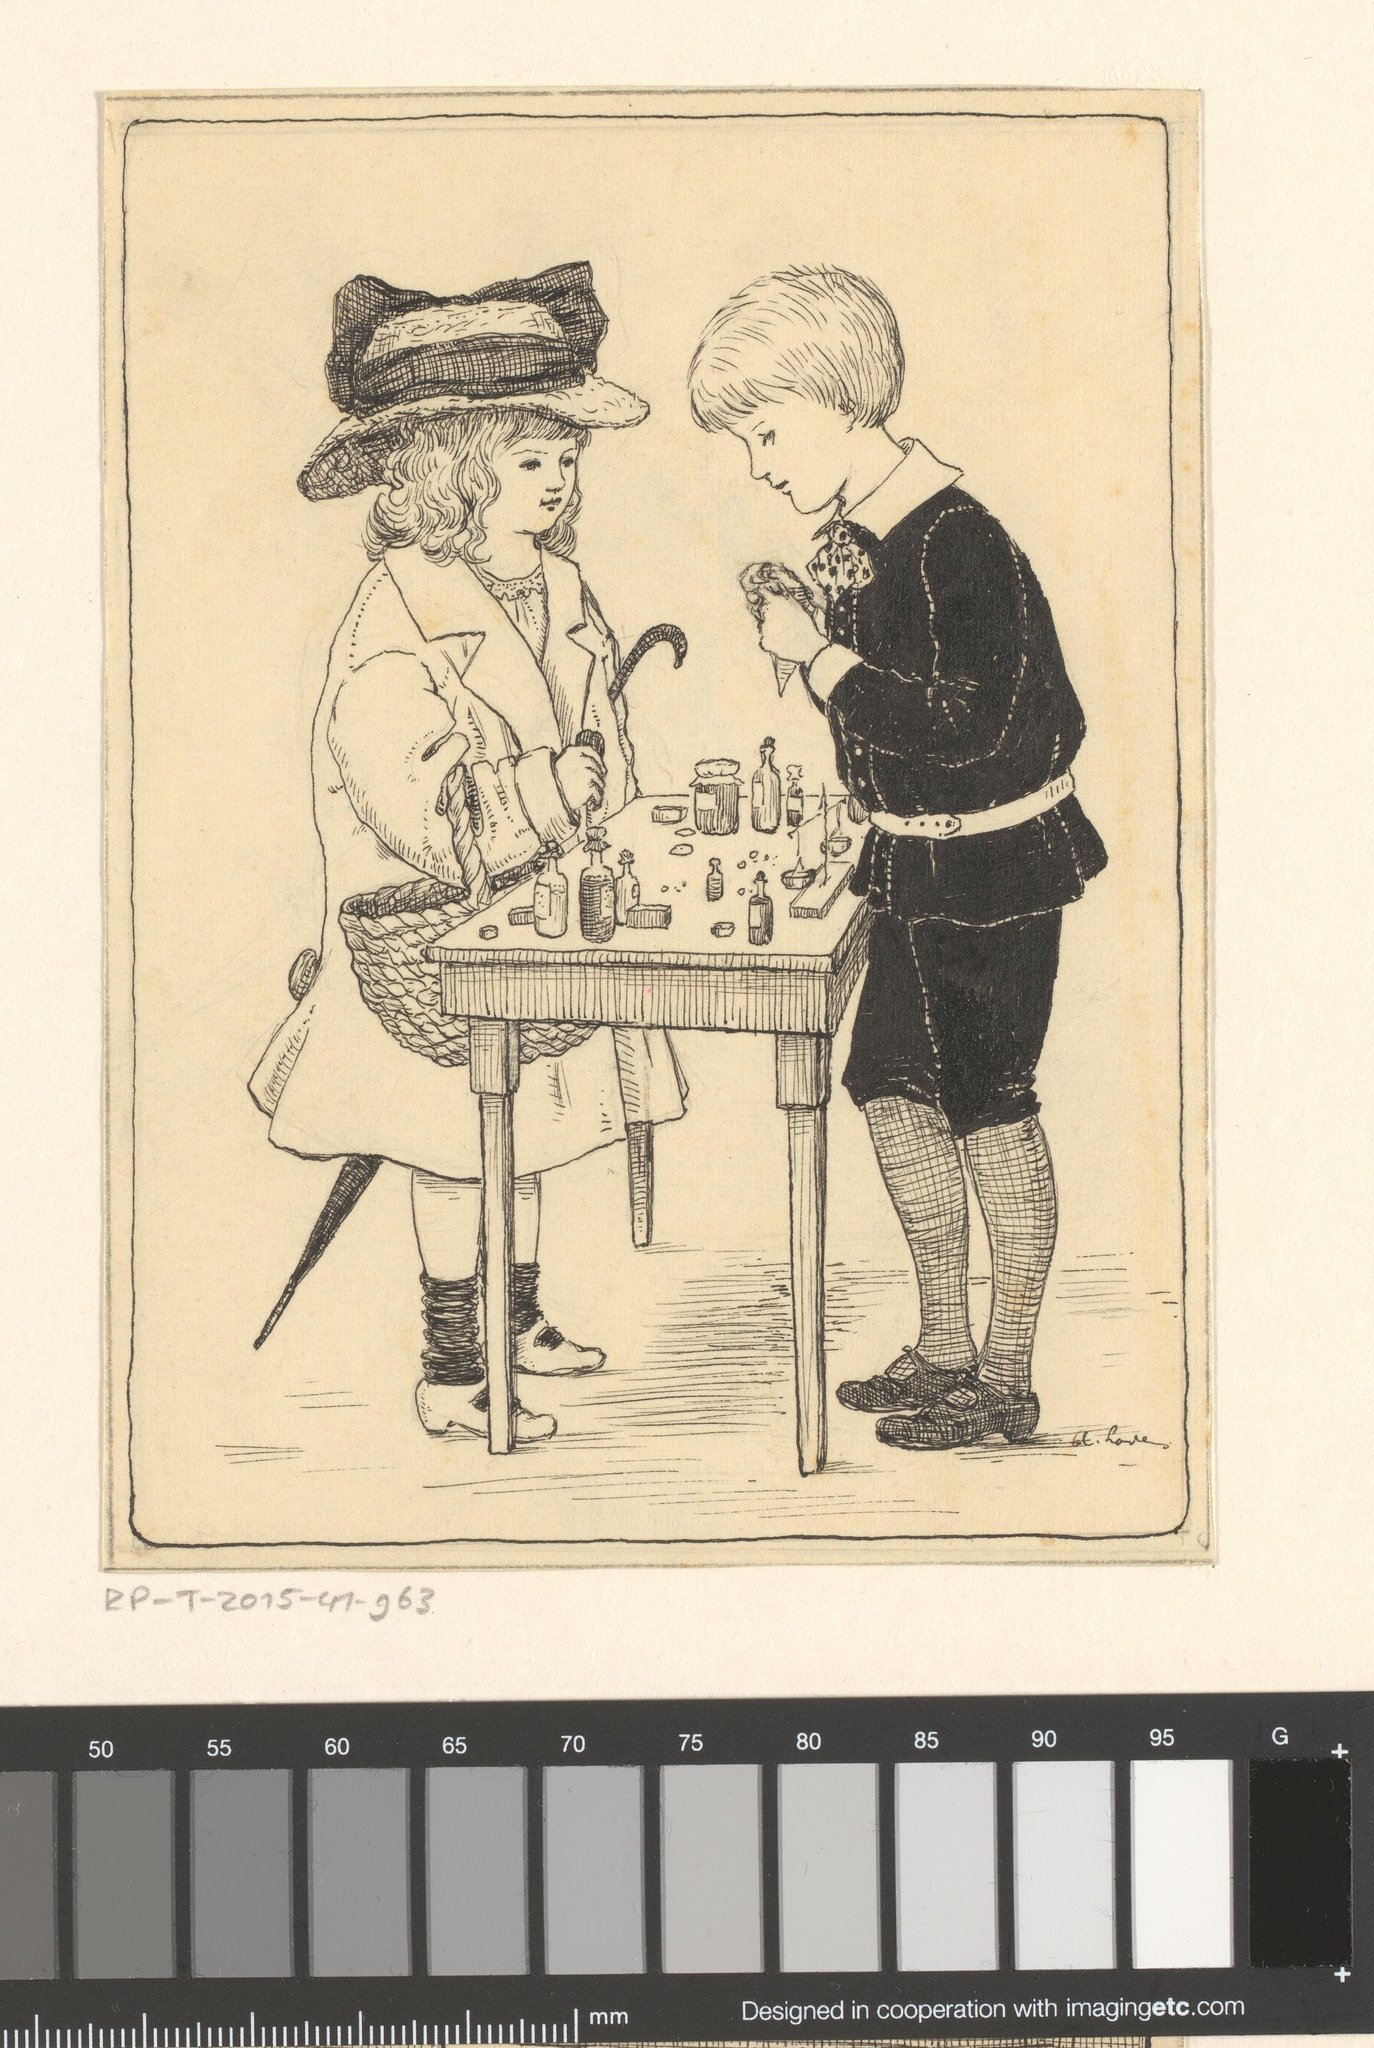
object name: drawing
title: Rie en Jan spelen apotheekje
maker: adri ladenius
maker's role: draughtsman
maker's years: 1883-1953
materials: ink, paper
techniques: pen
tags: other children's games, bottles (ampullae)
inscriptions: signature: ‘A. Lade’, :, collector's mark: Lugt 2228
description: Jan staat achter een tafel waarop flesjes, potjes en een weegschaal staan. Rie, met een hoed, een paraplu in de hand en mand om de arm, staat aan de overzijde van de tafel.